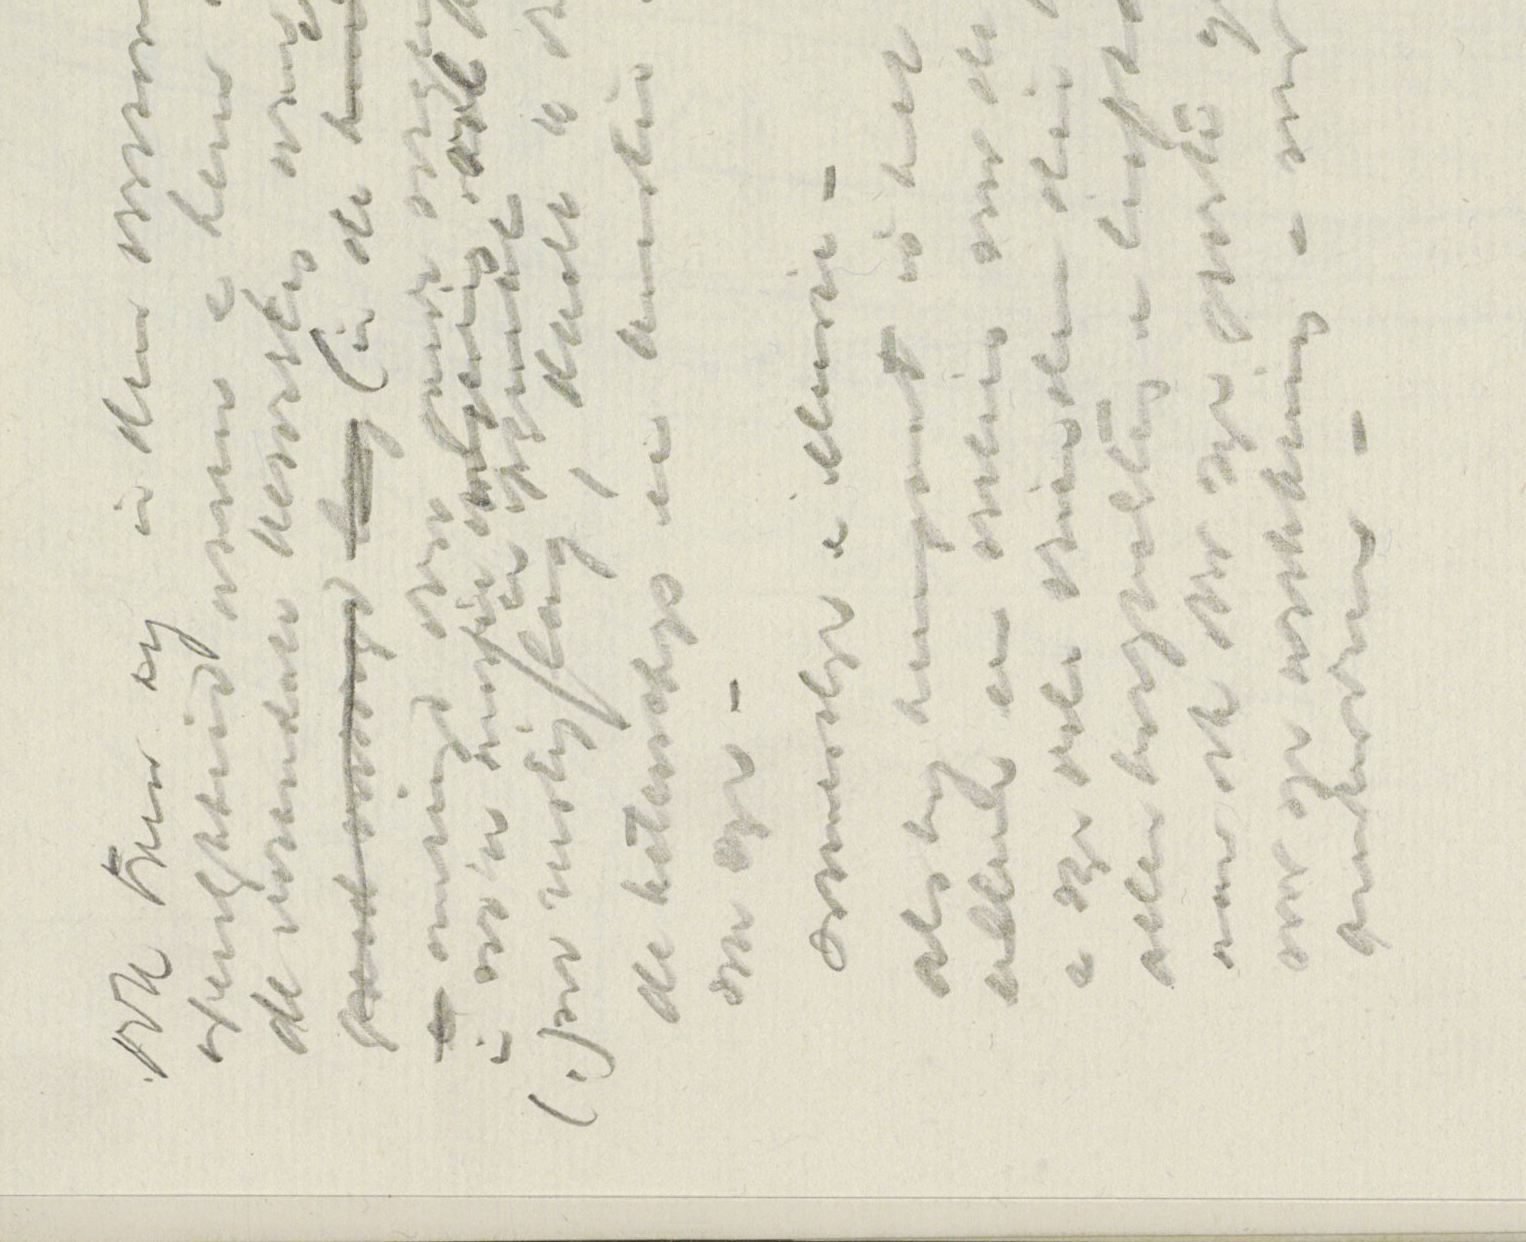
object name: sketchbook leaf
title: Annotaties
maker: willem witsen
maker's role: draughtsman, painter, print maker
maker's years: 1860-1923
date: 1915-1921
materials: paper, pencil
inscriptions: annotation: ‘[...]’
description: Blad 21 recto uit een schetsboek met 23 bladen.